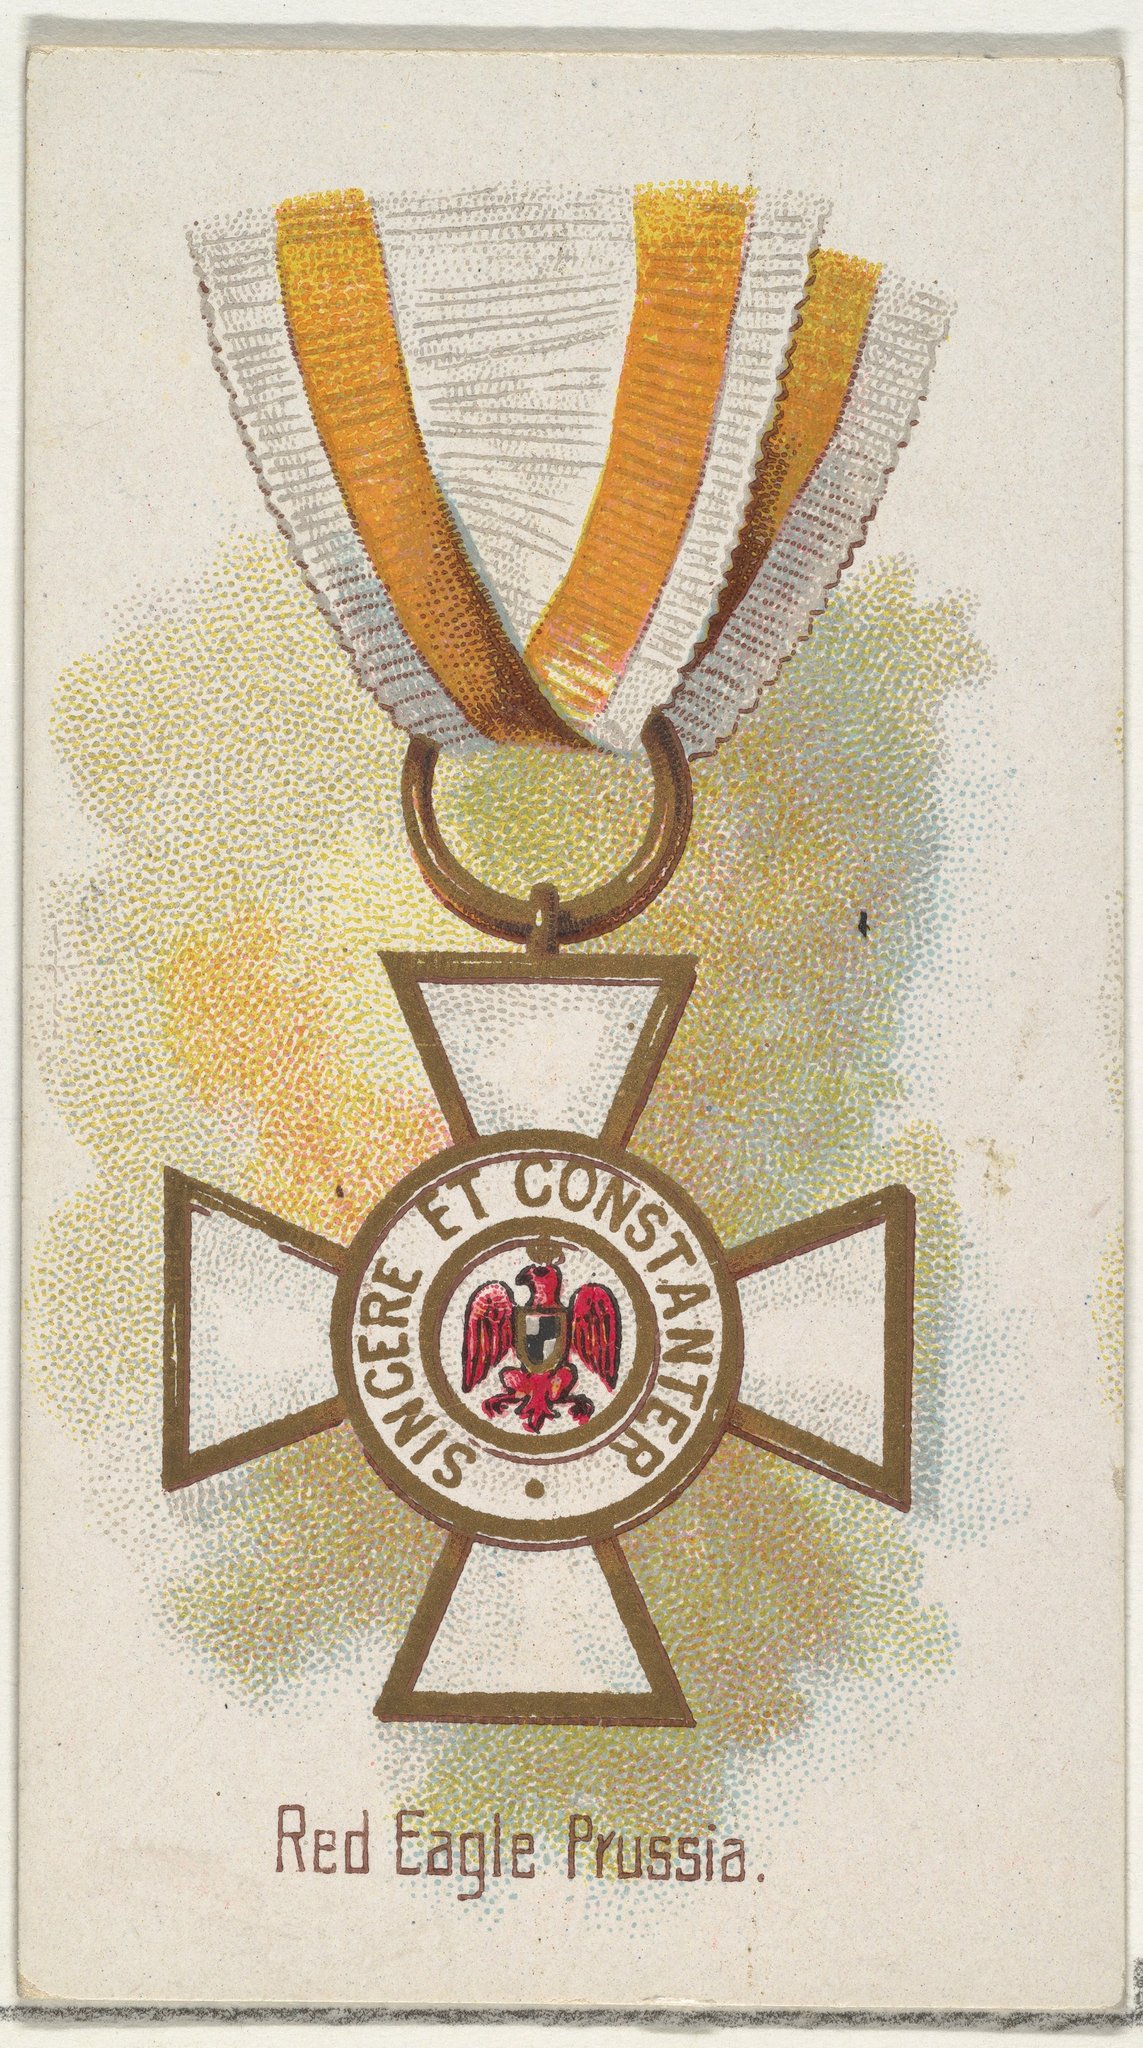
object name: print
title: Red Eagle, Prussia, from the World's Decorations series (N30) for Allen & Ginter Cigarettes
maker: allen & ginter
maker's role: publisher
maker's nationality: american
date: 1890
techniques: color lithograph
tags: medals